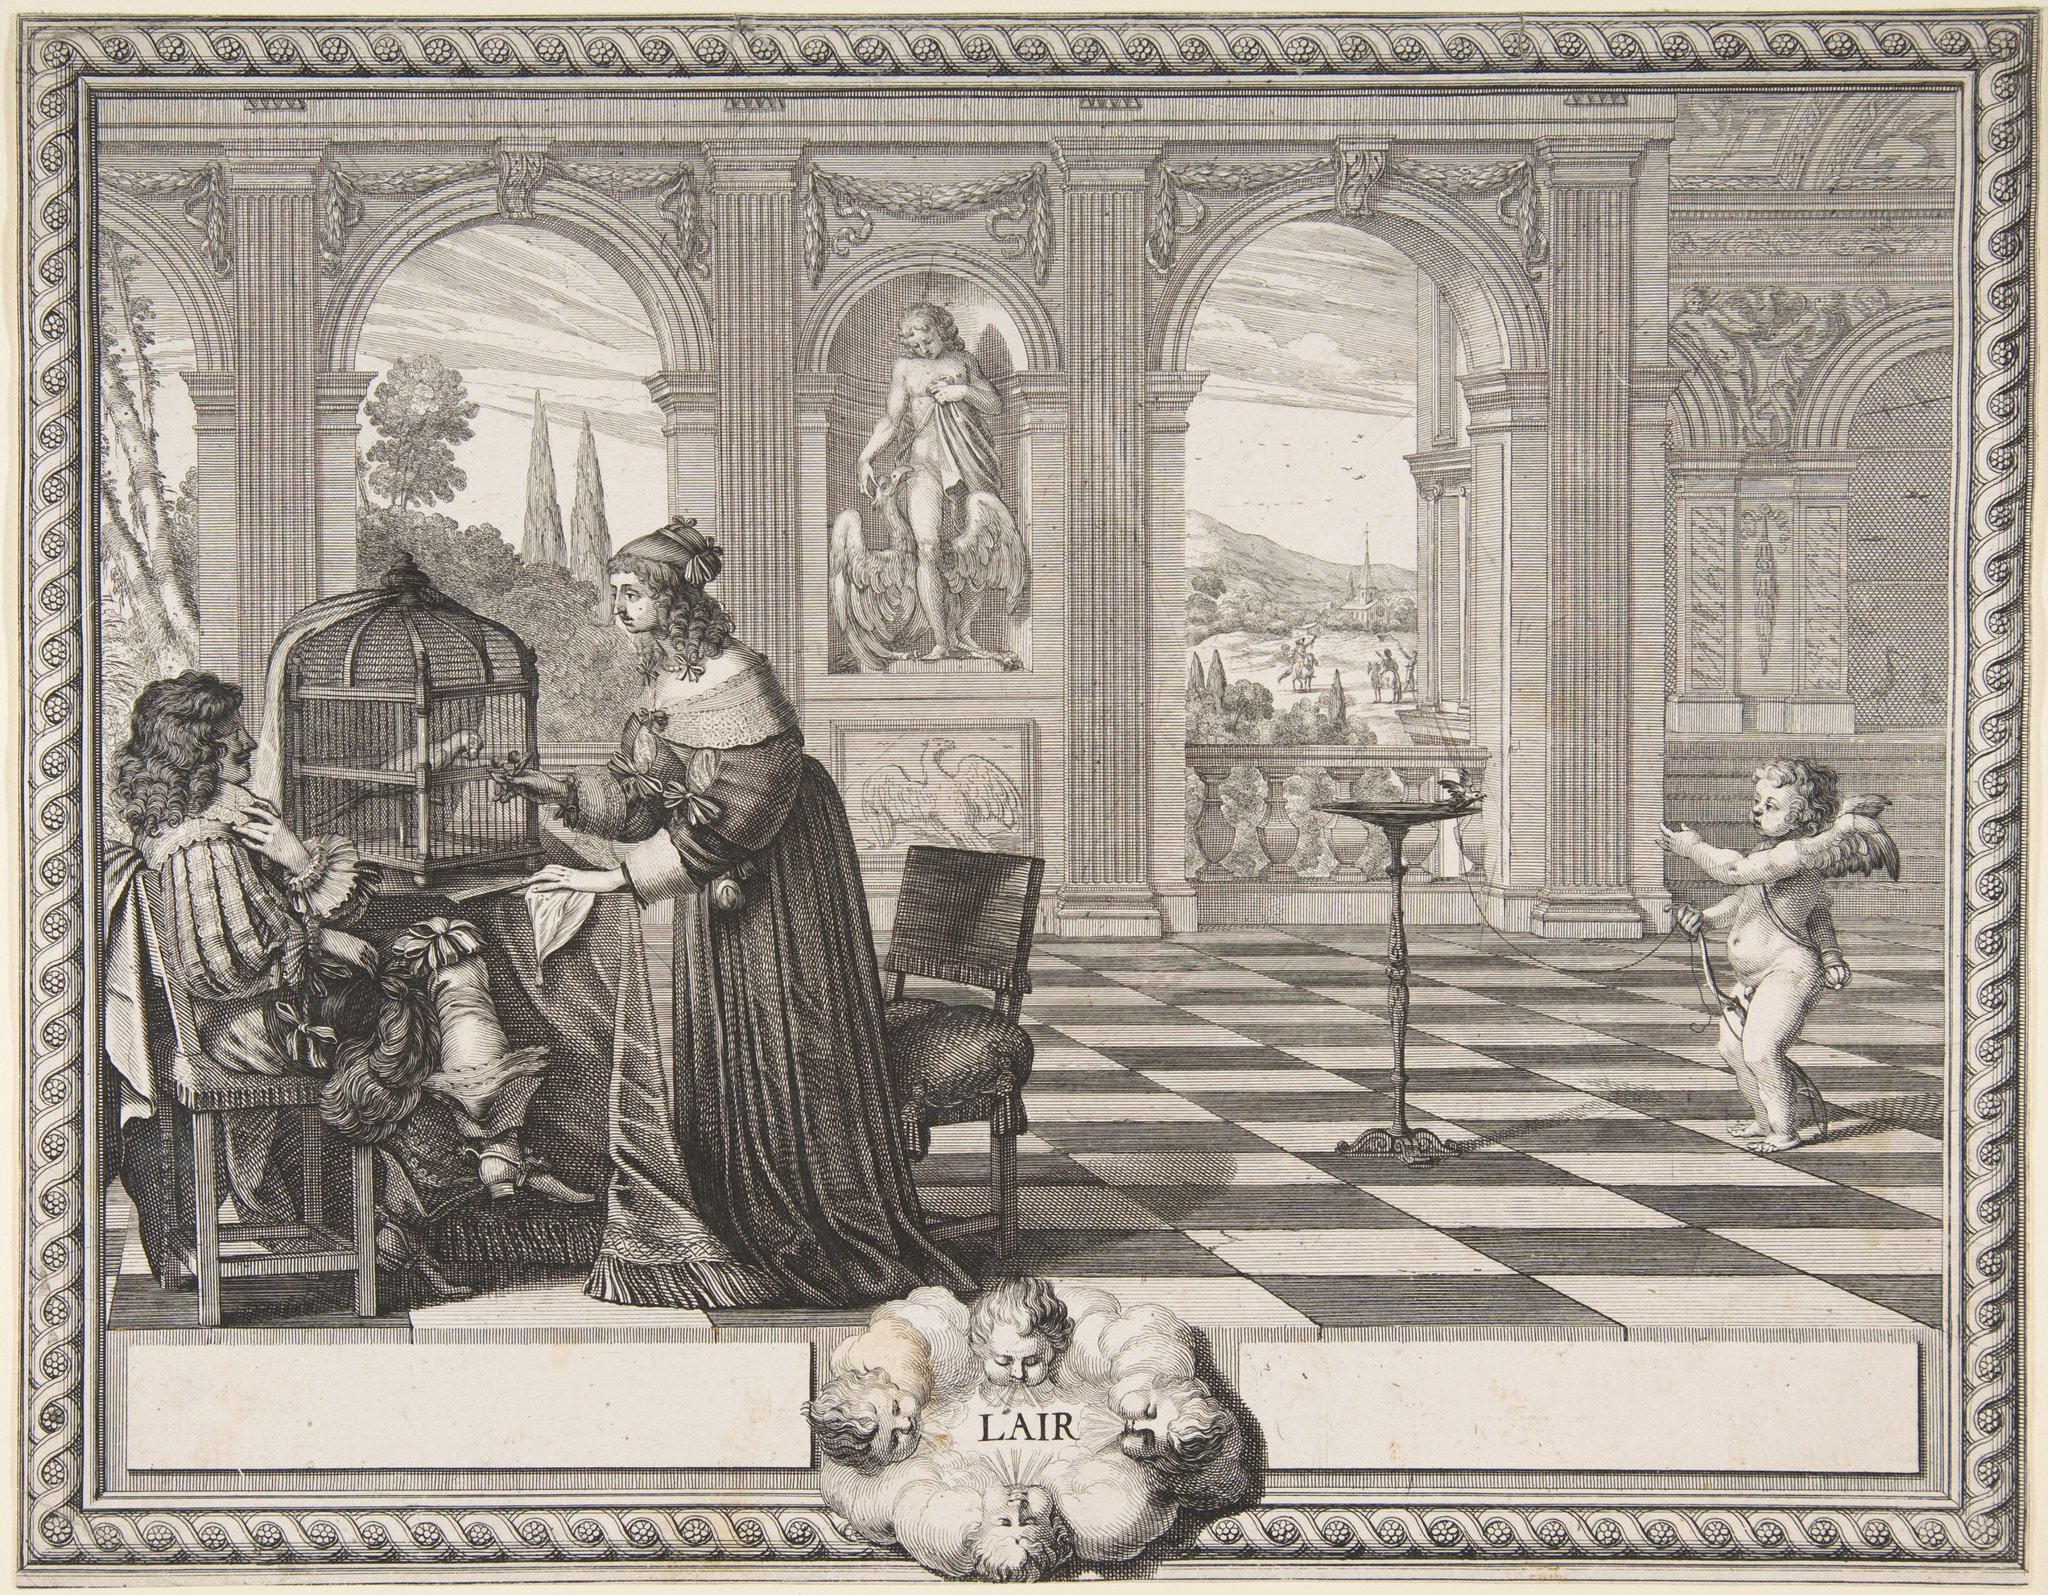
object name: print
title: Air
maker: abraham bosse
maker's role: artist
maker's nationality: french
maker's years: 1602-1676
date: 1648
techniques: etching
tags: men,women,parrots